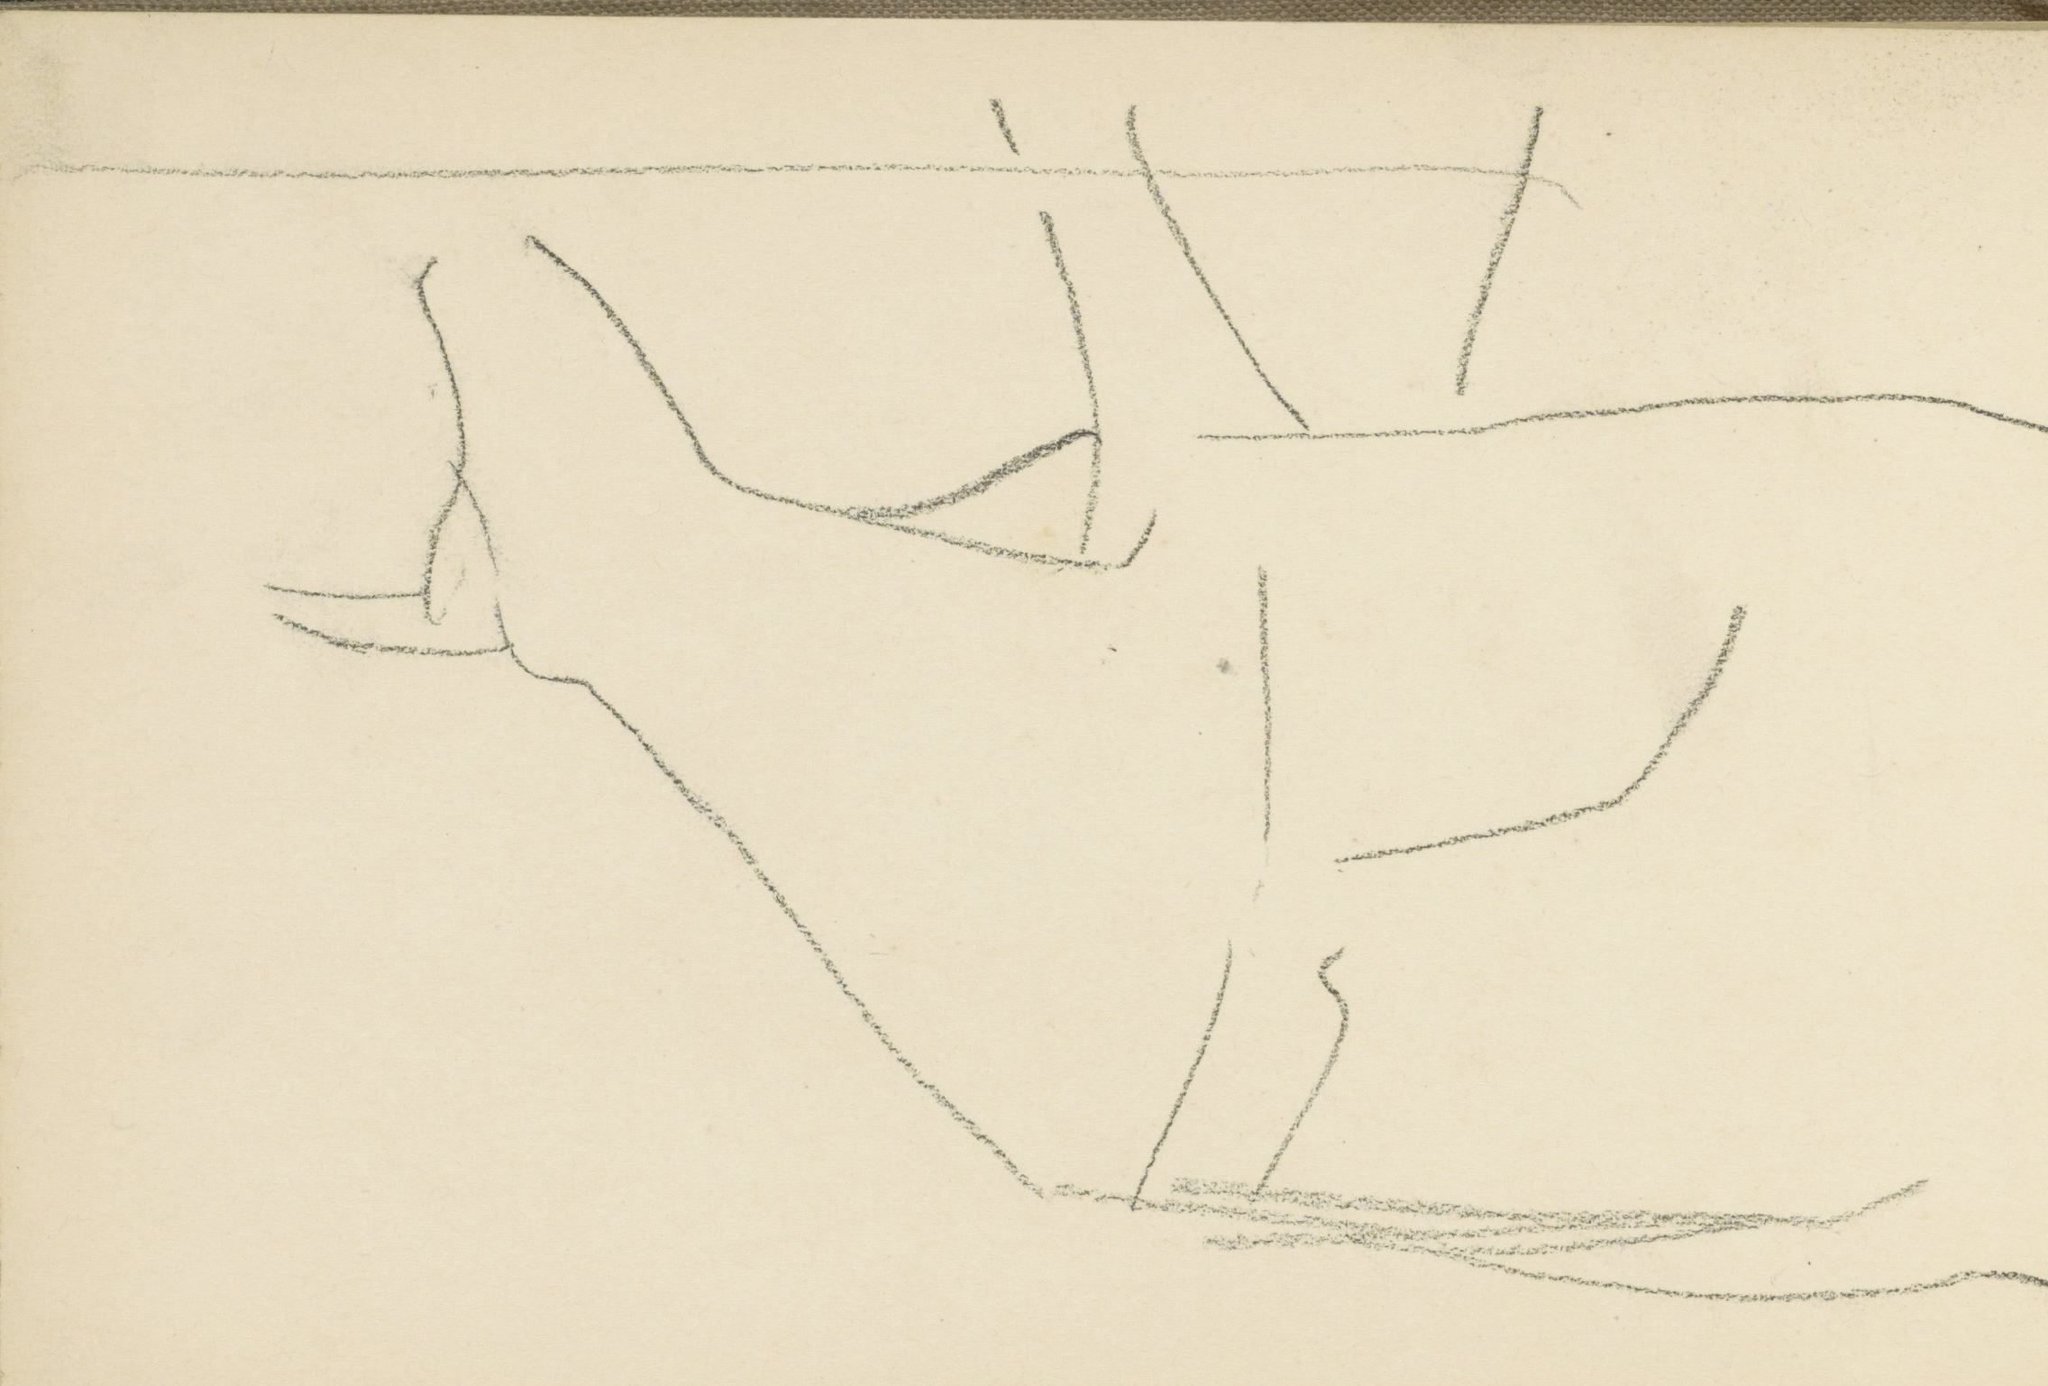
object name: sketchbook leaf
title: Koe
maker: carel adolph lion cachet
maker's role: draughtsman, print maker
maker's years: 1864-1945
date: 1905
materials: chalk, paper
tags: cow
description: Blad 24 verso uit een schetsboek met 27 bladen.